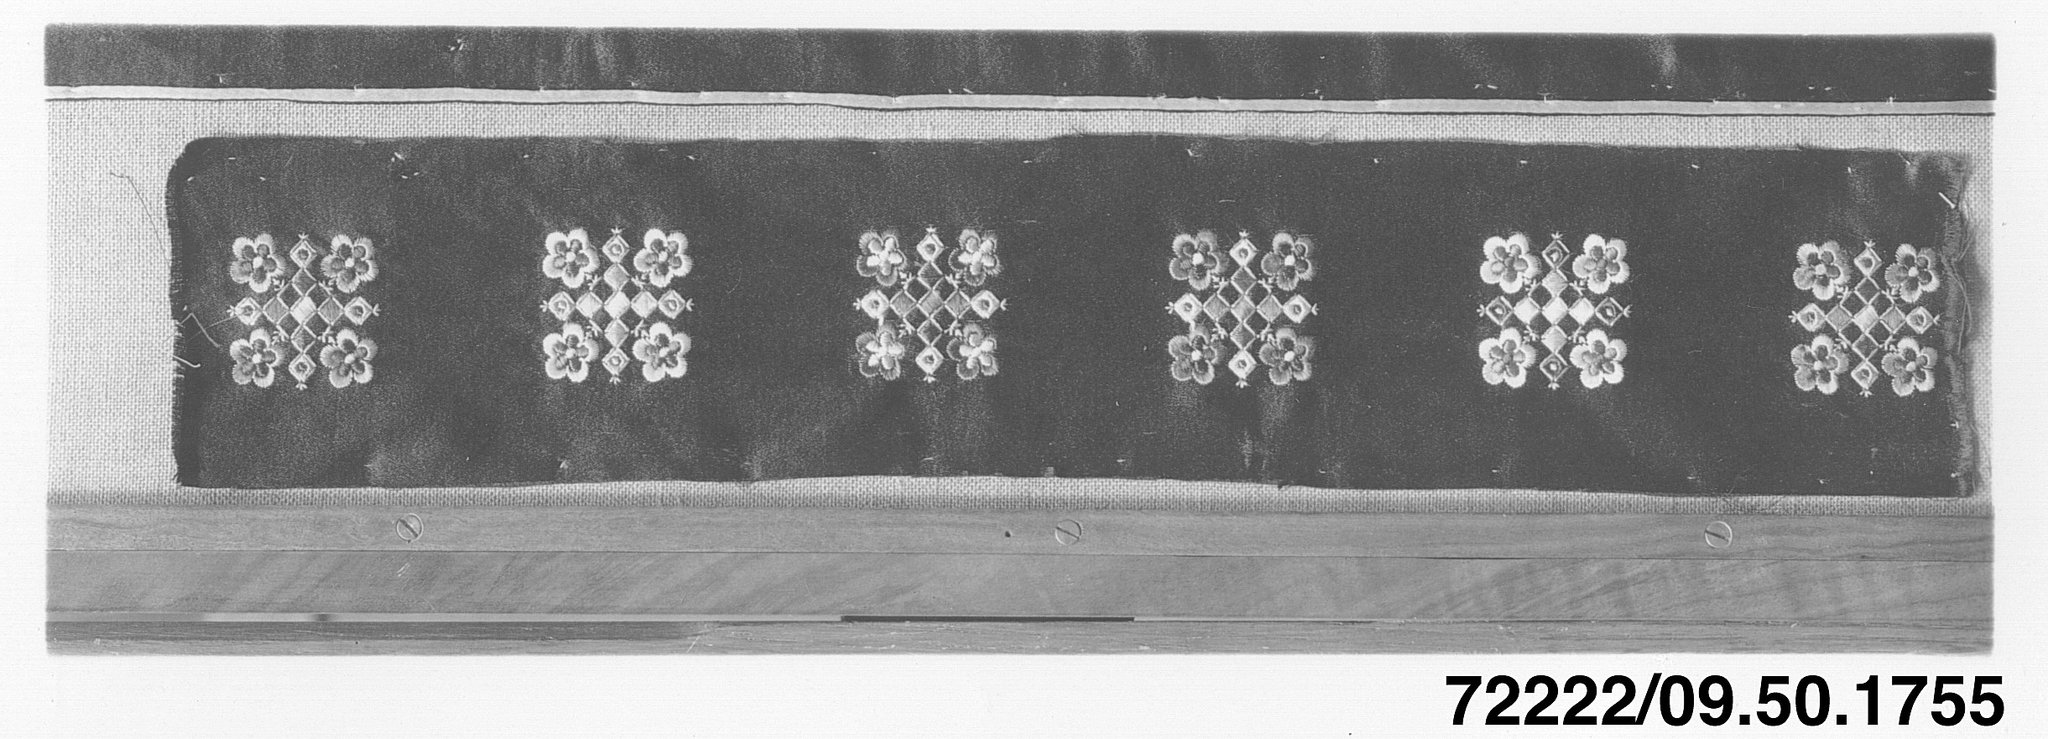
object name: fragment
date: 1801-1900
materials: silk